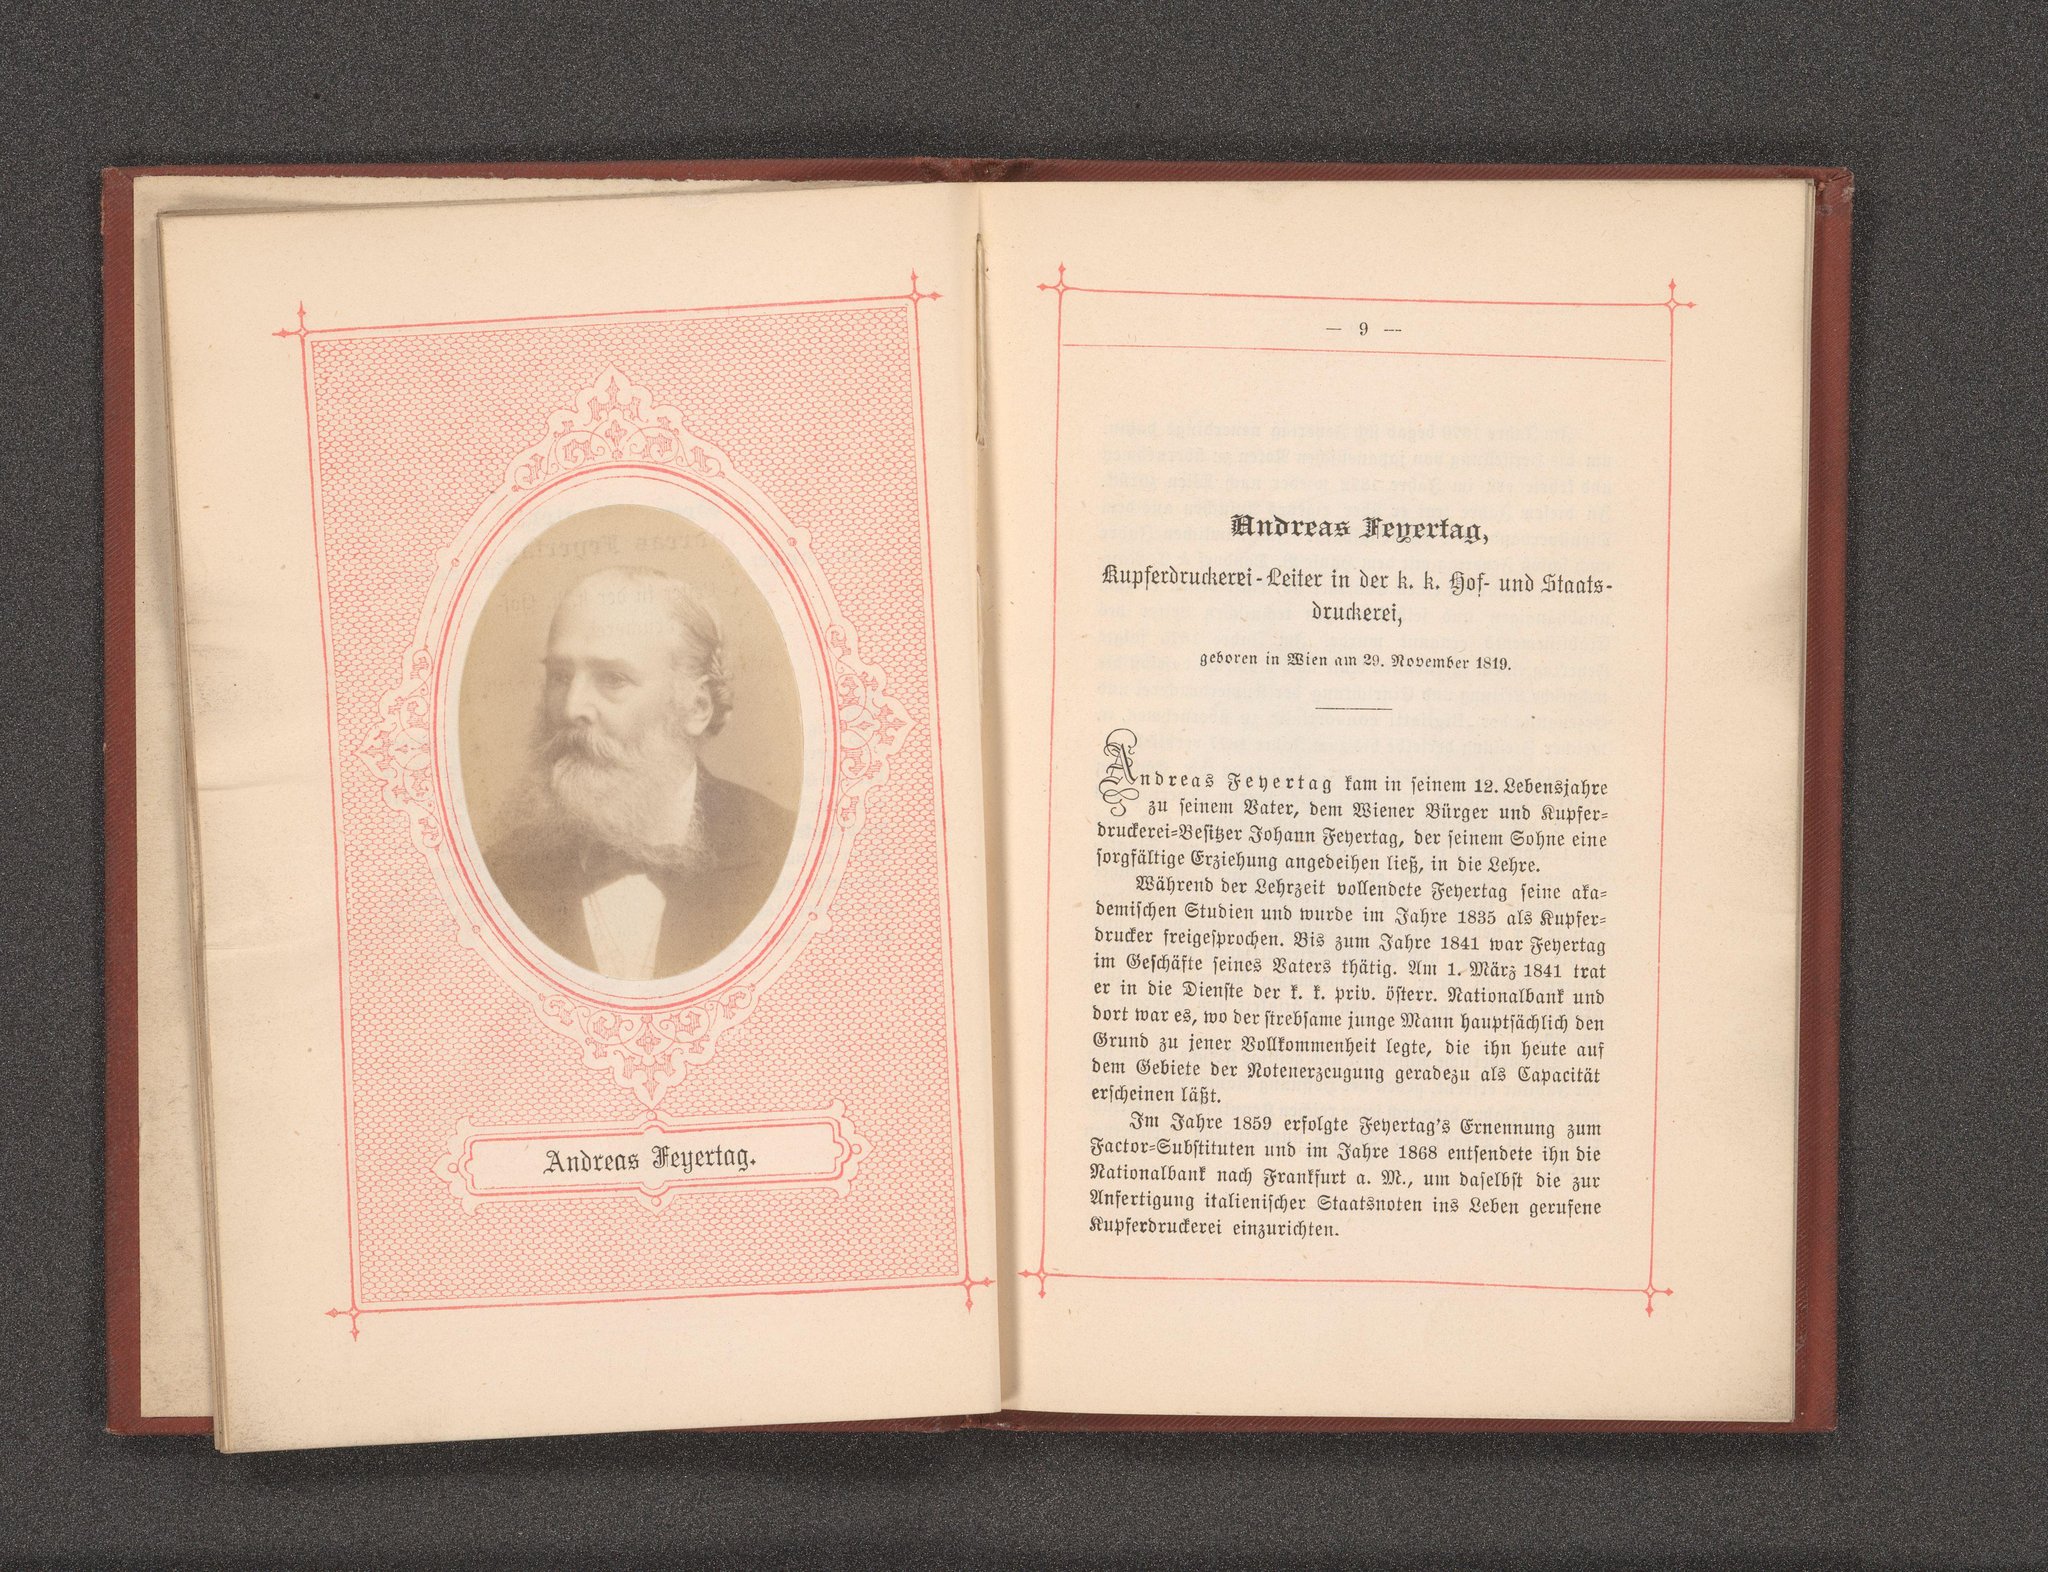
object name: page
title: Portret van Andreas Feyertag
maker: Anonymous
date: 1873-1883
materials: photographic support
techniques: albumen print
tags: printer